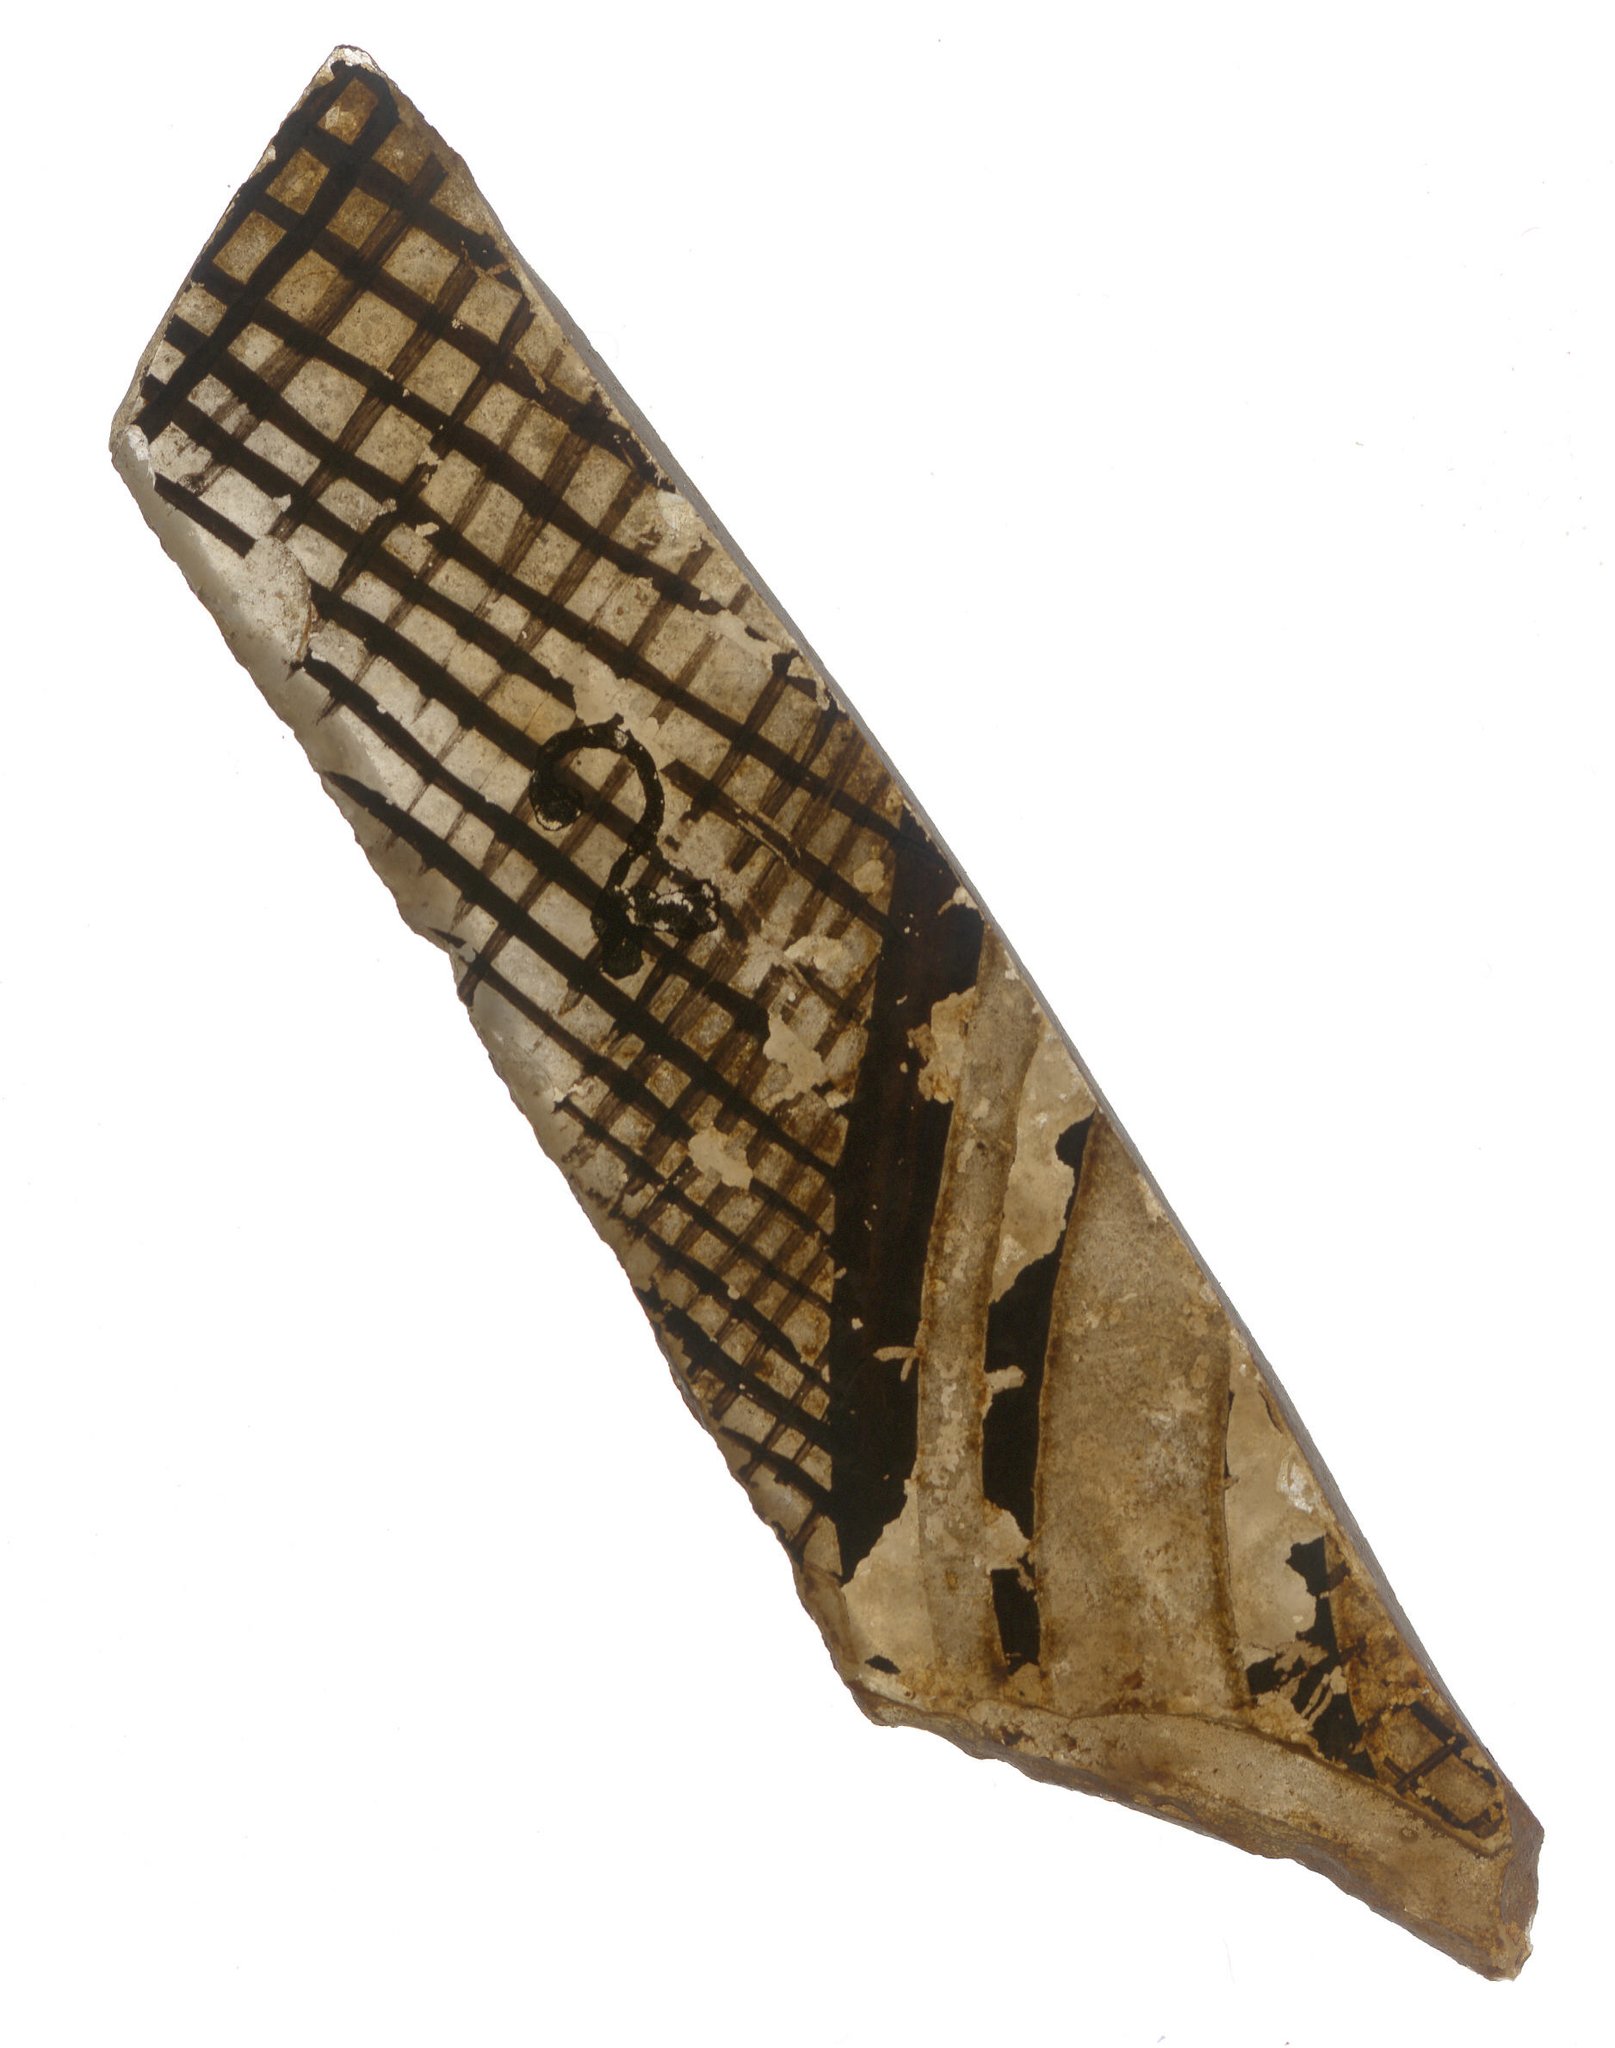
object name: fragment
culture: crusader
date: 1201-1300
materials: glass